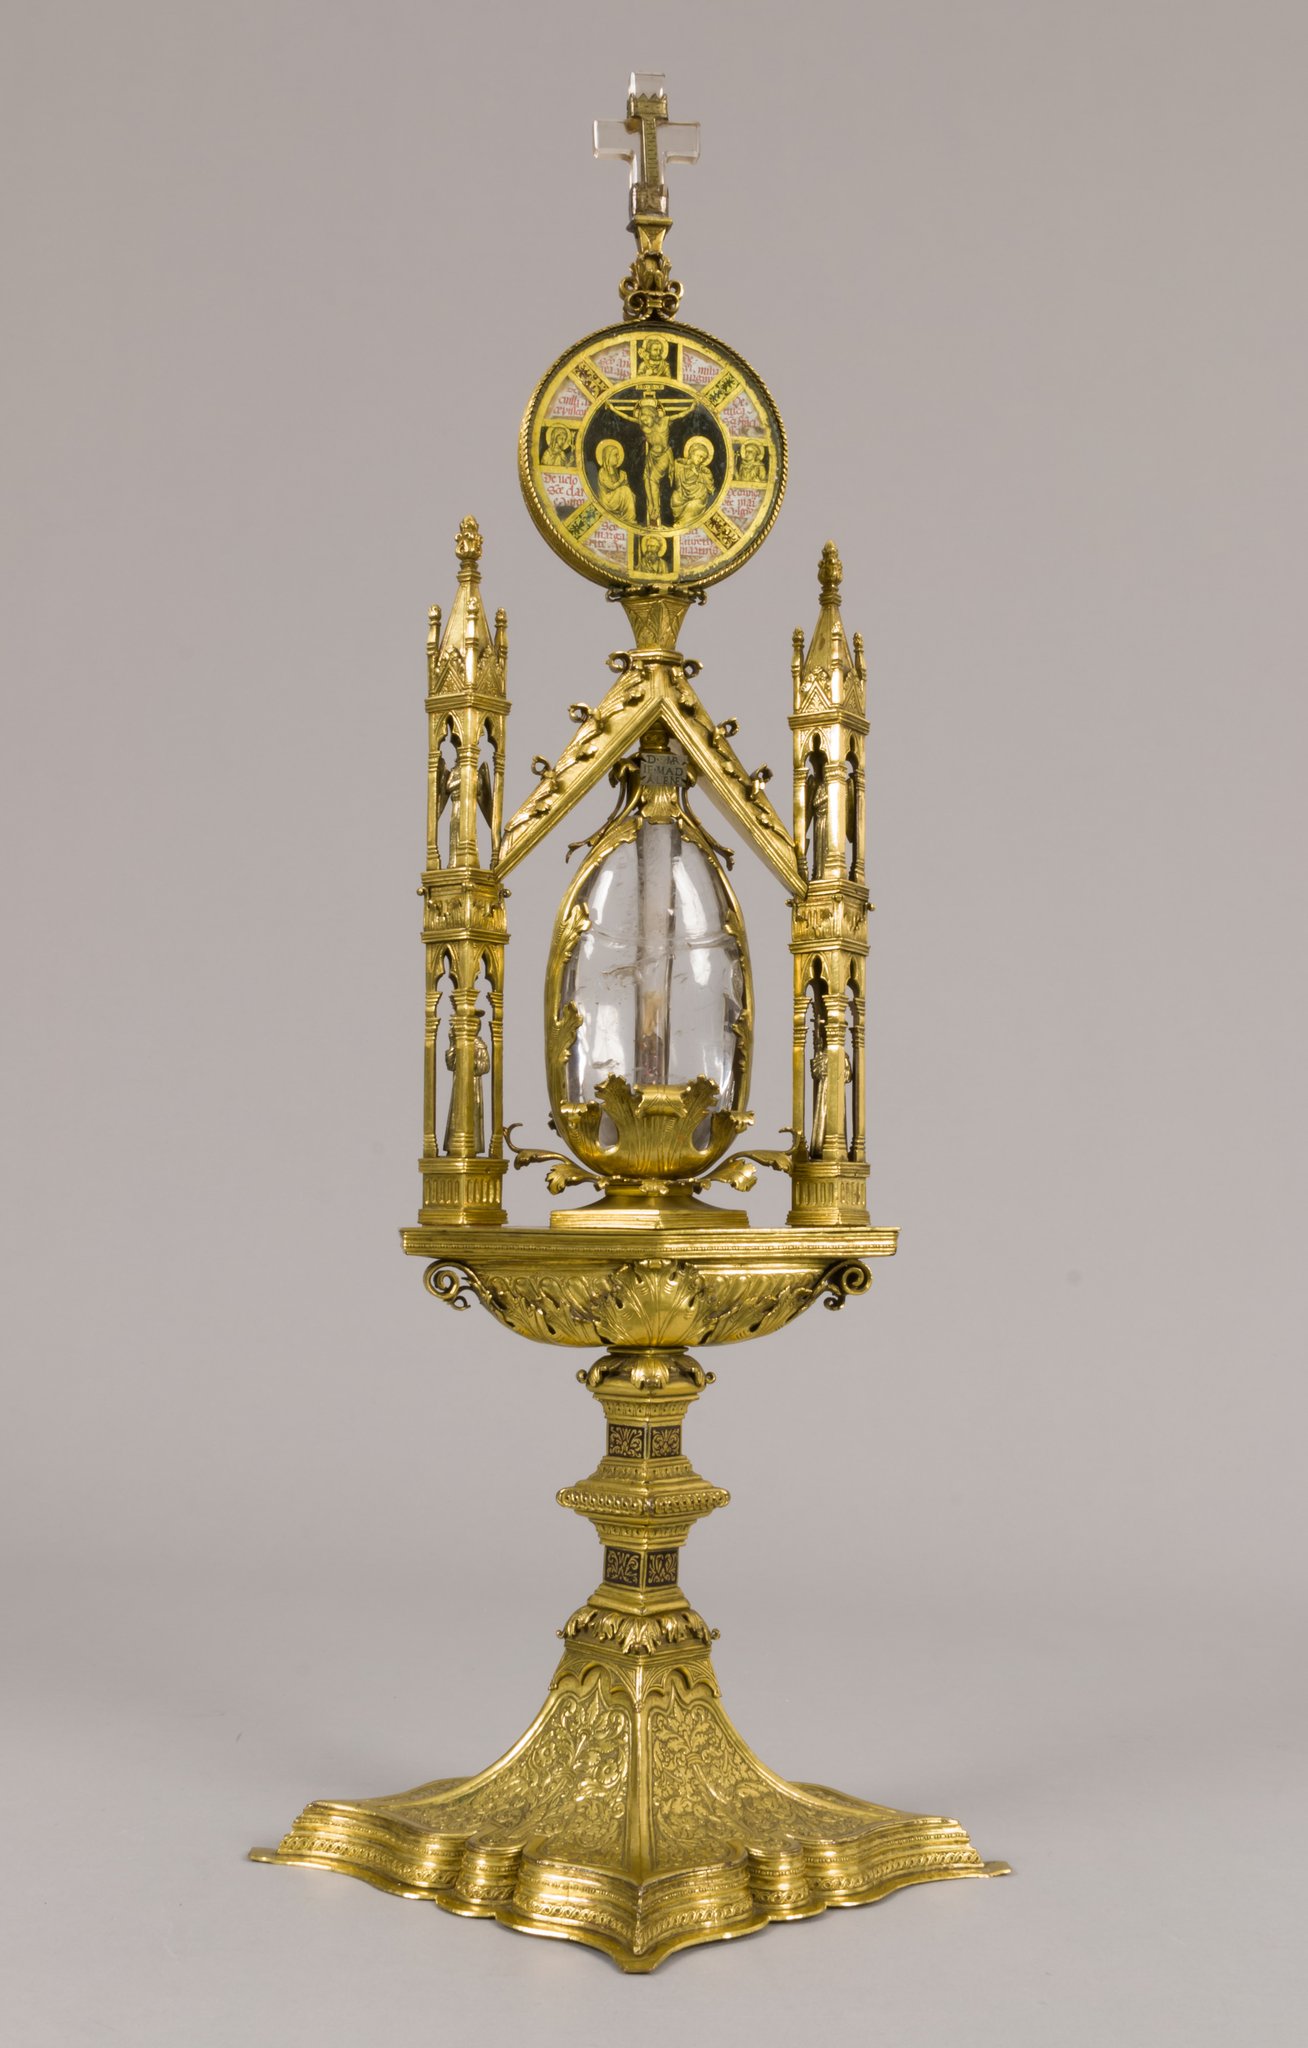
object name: reliquary monstrance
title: Reliquary of Mary Magdalene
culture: north italian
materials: gilt copper, gilt silver, quartz, pigment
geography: italy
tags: christ,mary magdalene,crucifixion